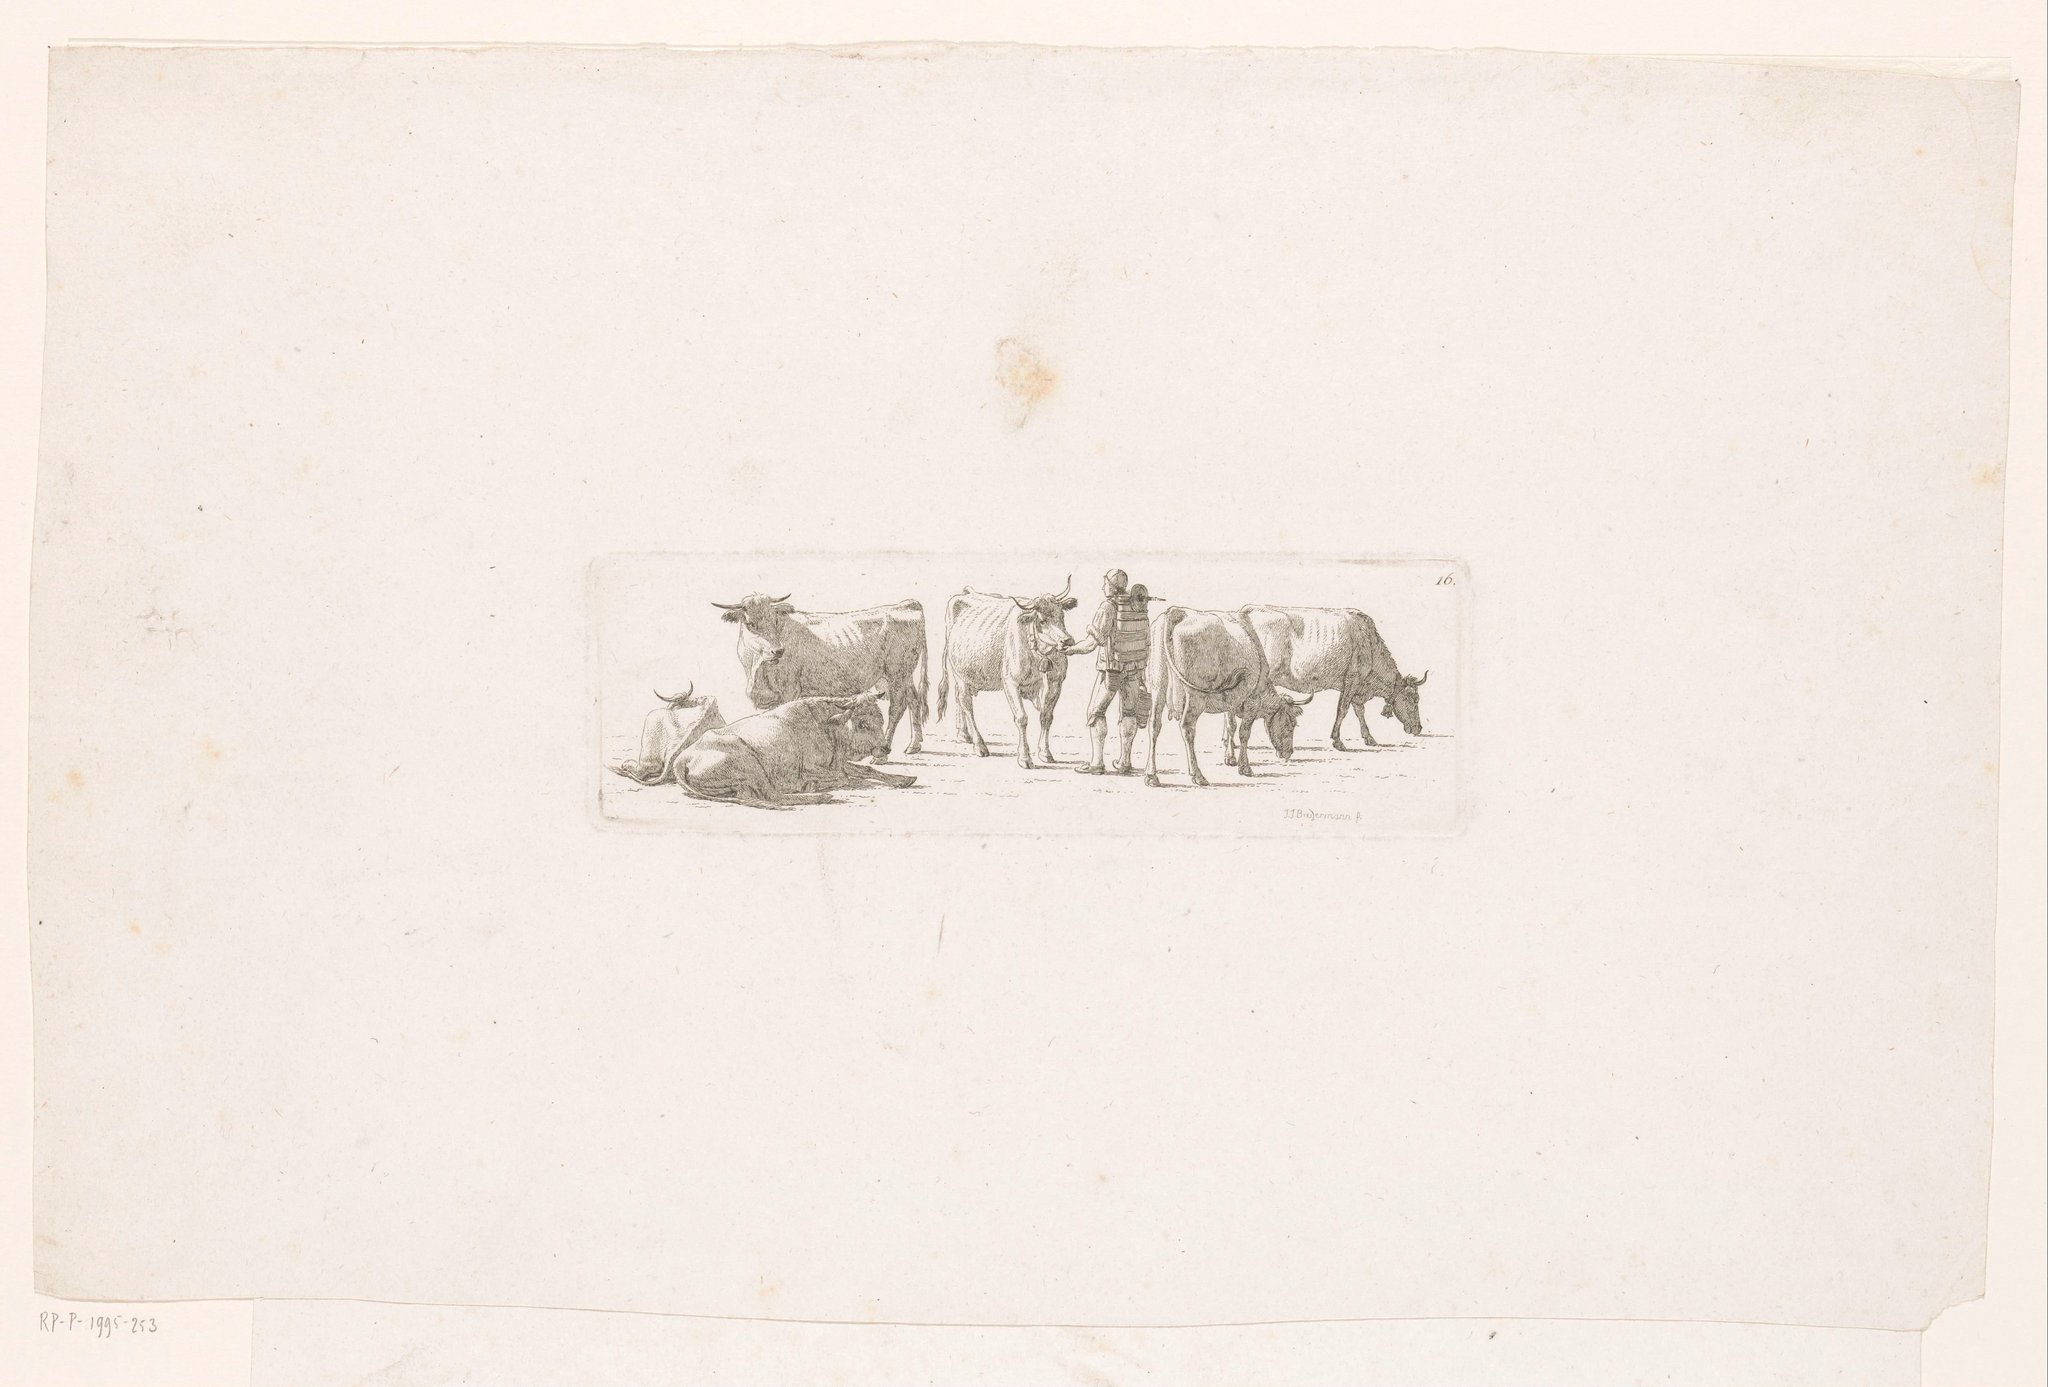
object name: print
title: Herder met zes runderen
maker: johan jakob biedermann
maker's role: painter, print maker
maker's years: 1763-1830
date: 1778-1830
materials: paper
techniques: etching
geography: switzerland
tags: cow, herding, herdsman, herdswoman, shepherd, shepherdess, cowherd, etc.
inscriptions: watermark: ‘Thurneisen’, collector's mark: Lugt 2228